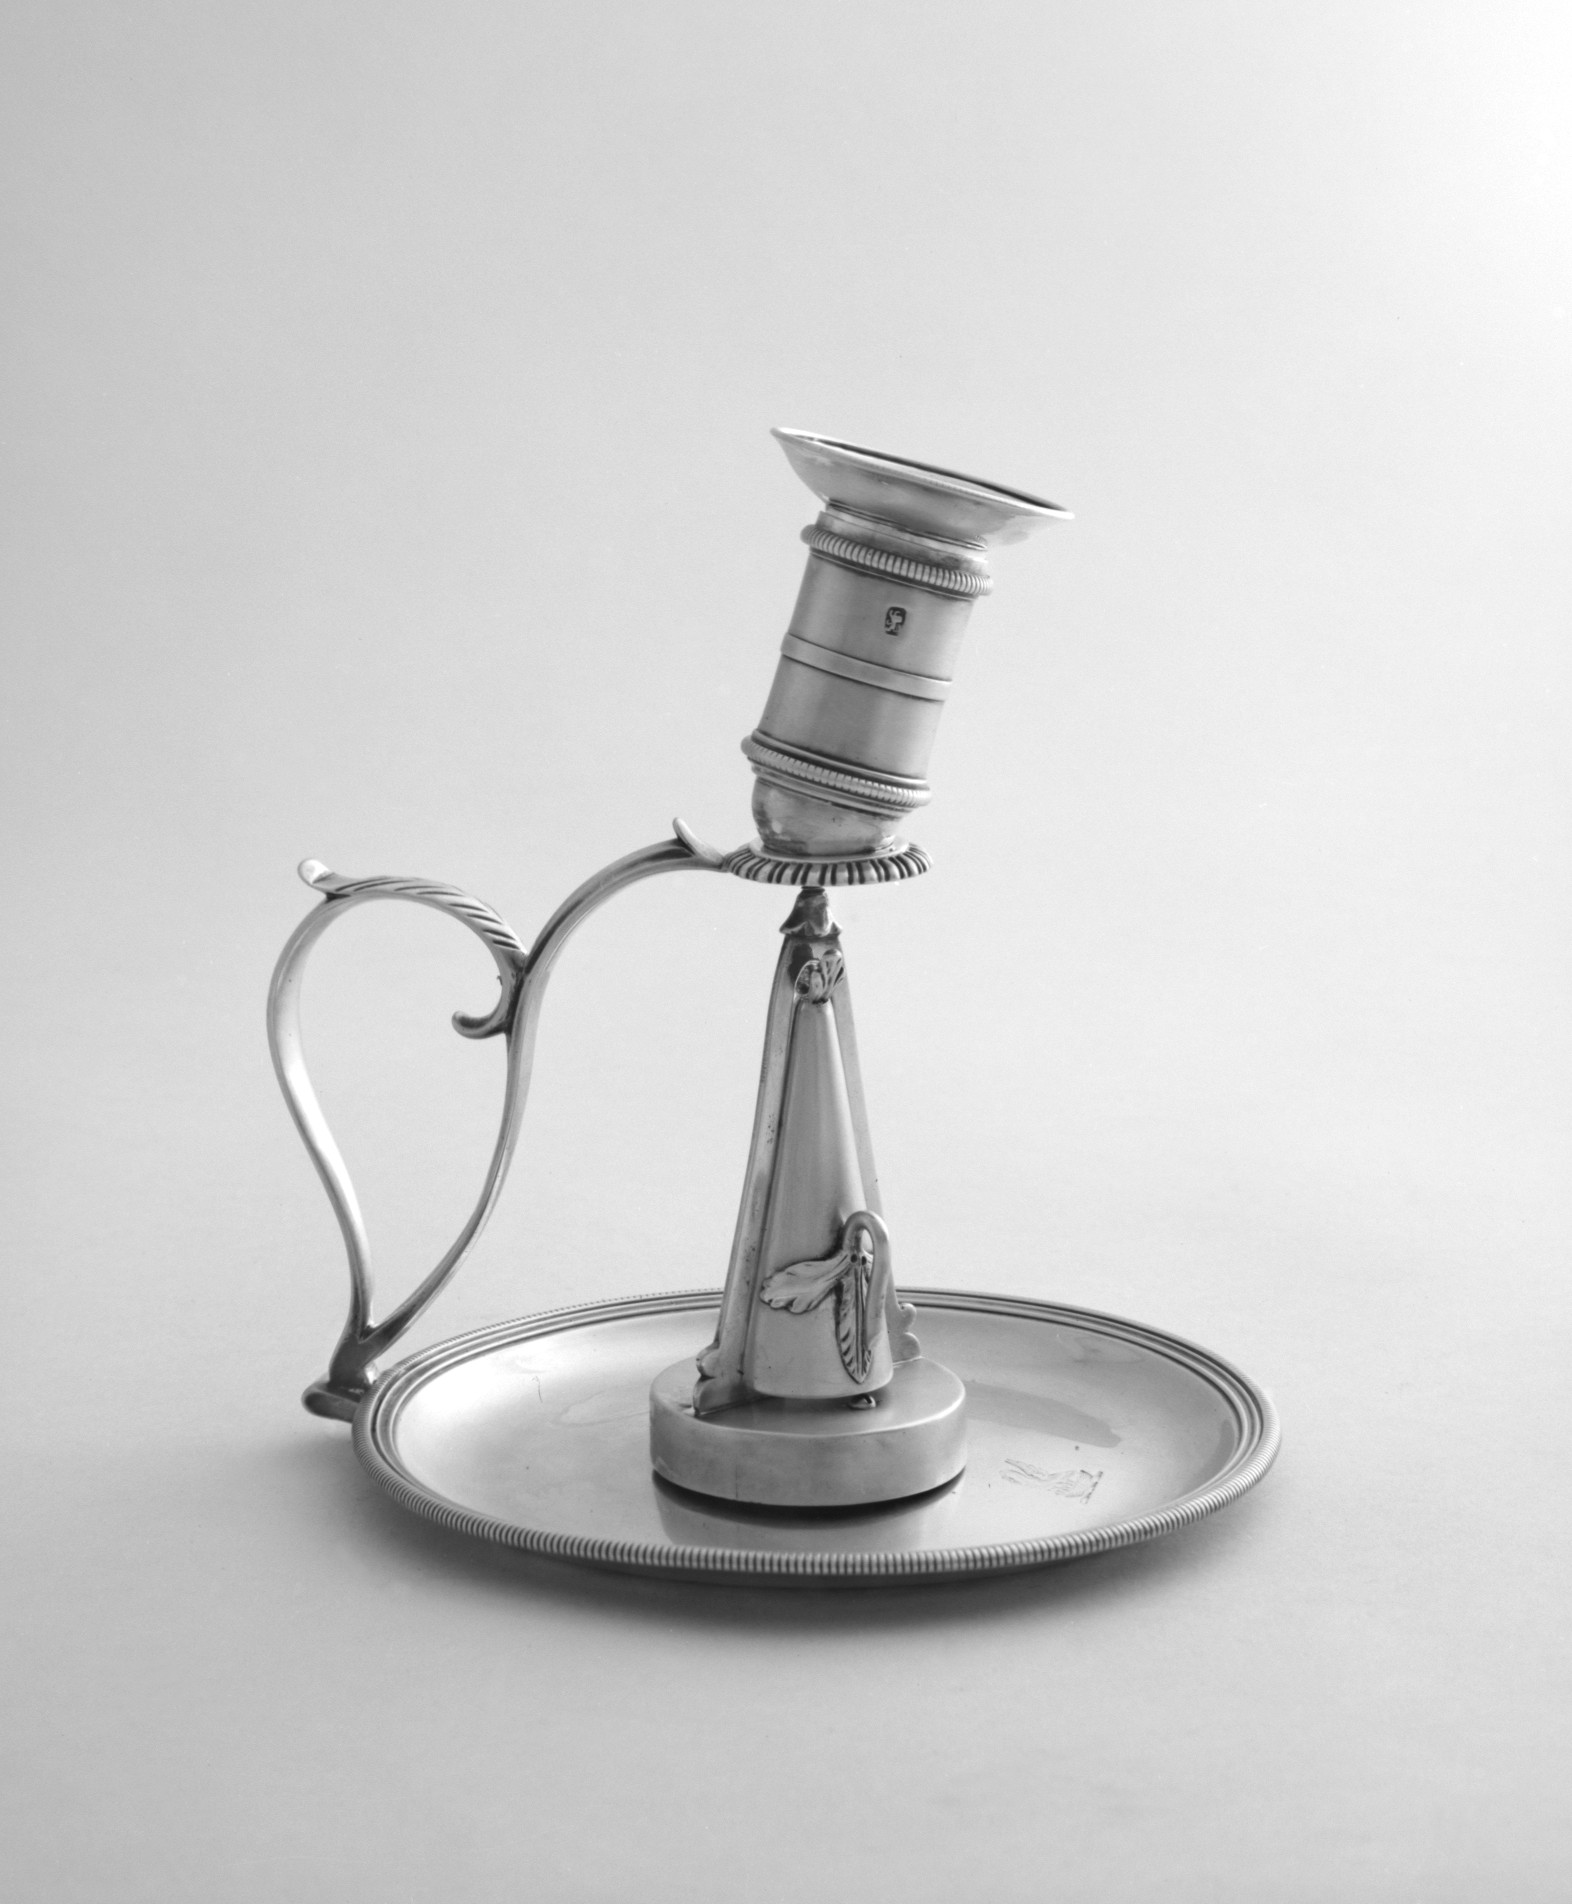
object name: chamber candlestick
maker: ebenezer coker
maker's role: maker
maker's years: 1683-1783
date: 1768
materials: silver